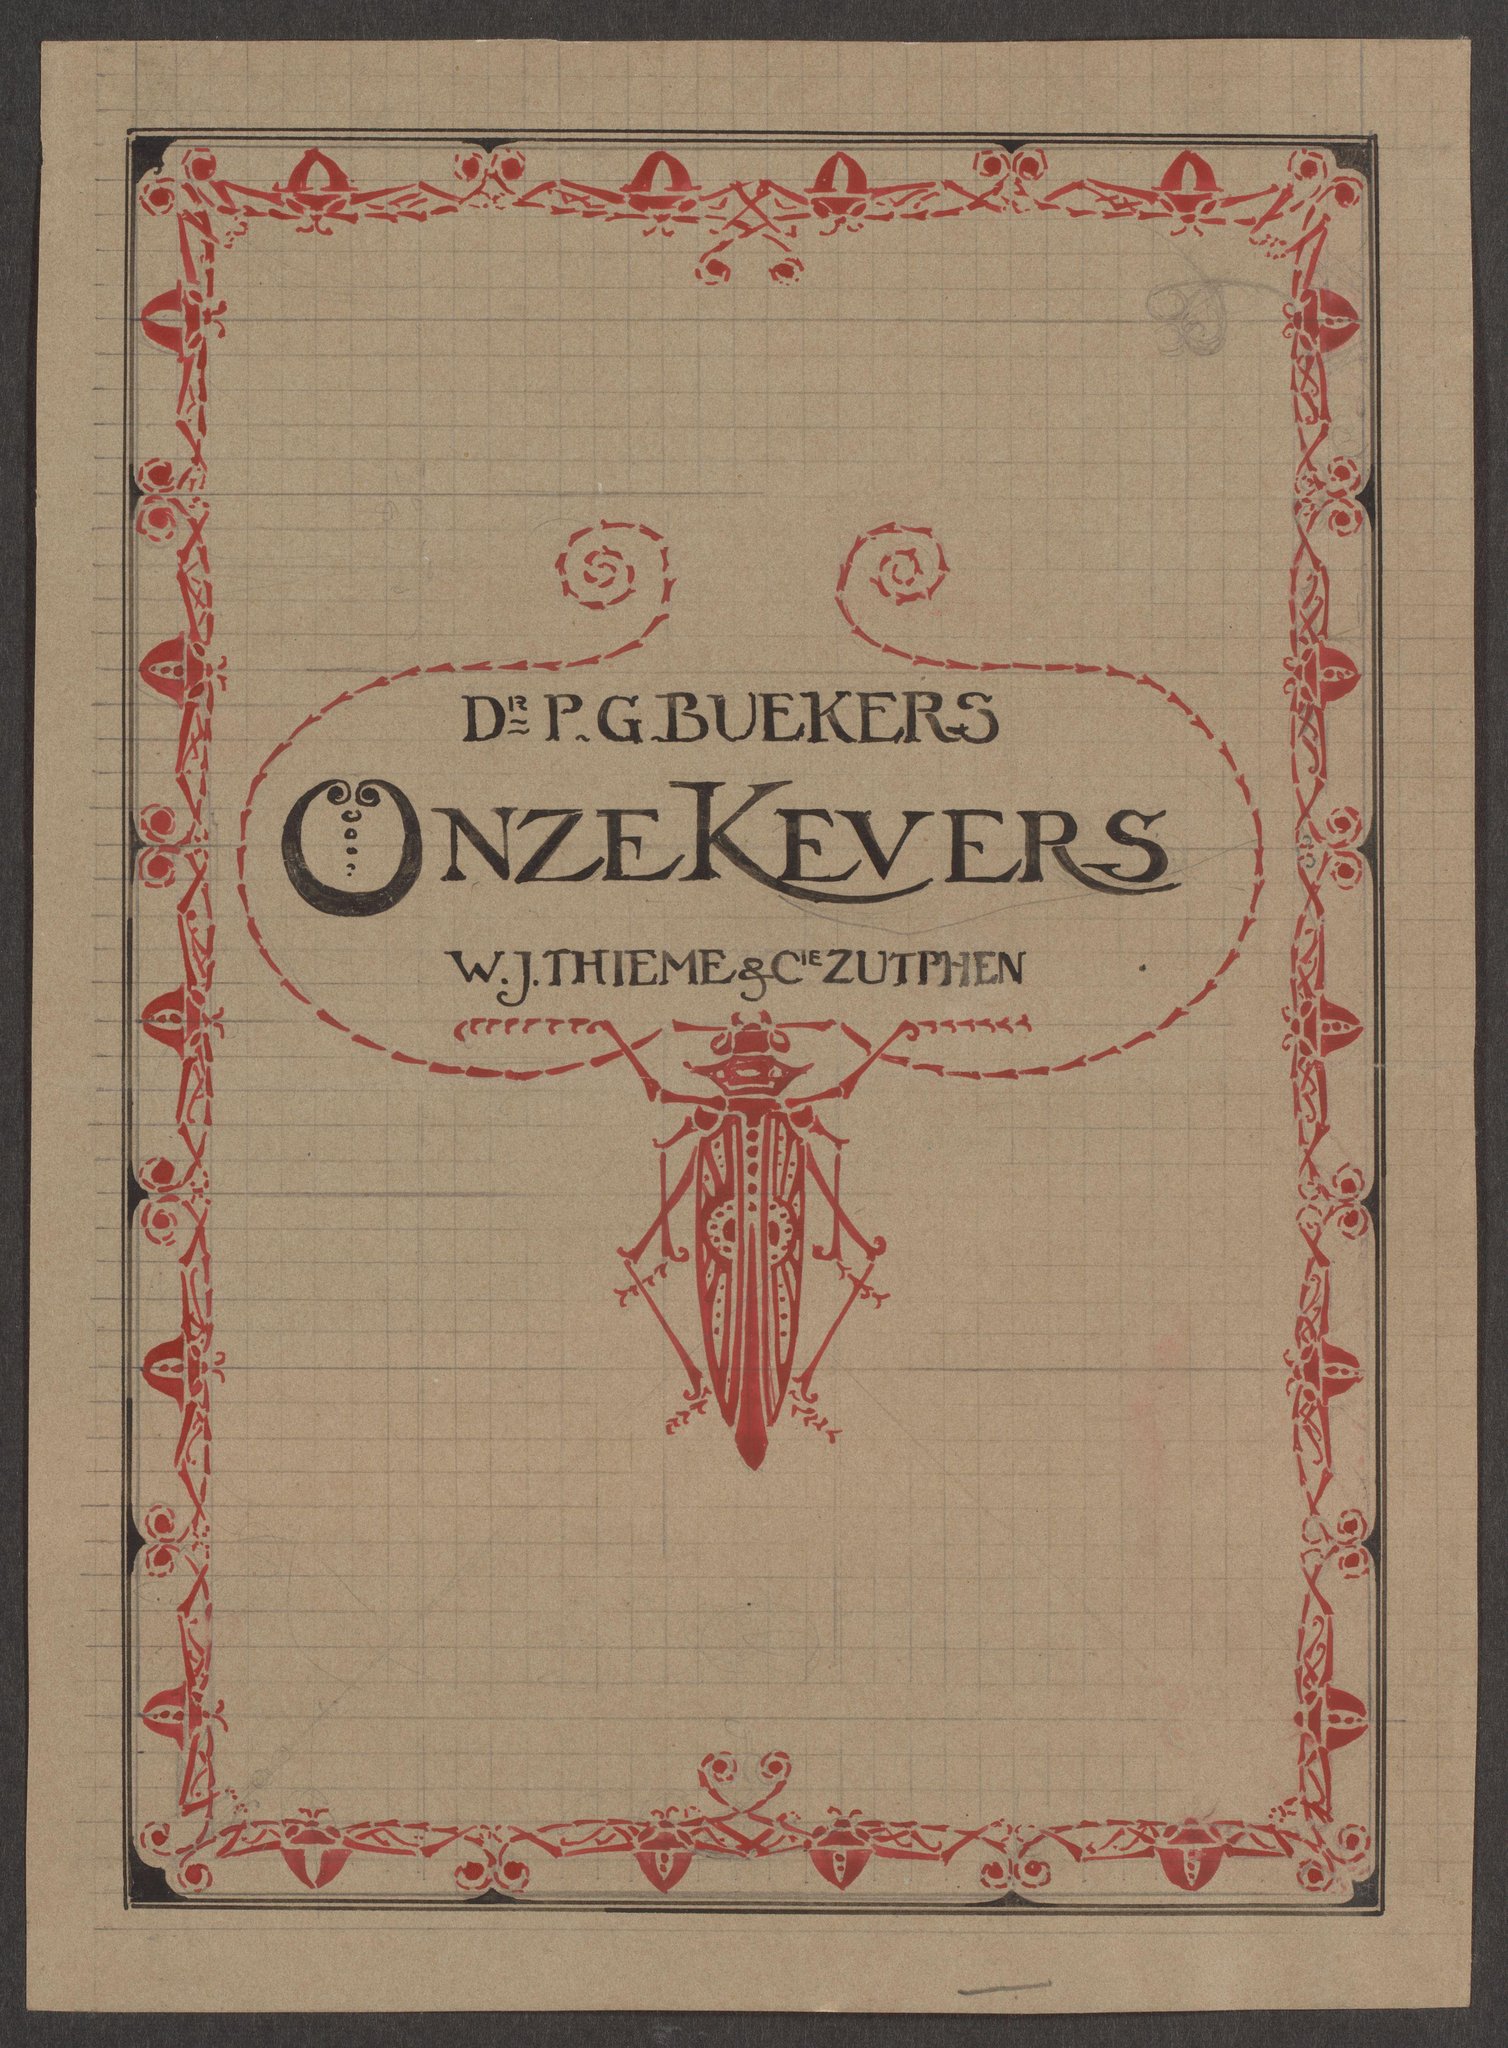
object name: study for binding design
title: Bandontwerp voor: P.G. Buekers, Onze kevers, 1912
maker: reinier willem petrus de vries (1874-1953)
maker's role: draughtsman, print maker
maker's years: 1874-1953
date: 1912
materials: ink, paint, paper, pencil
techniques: brush, pen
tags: insects: beetle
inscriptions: number: ‘No3’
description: Ontwerp voor: Buekers, Dr. P.G. Onze kevers. Zutphen: W.J. Thieme & cie, 1912.